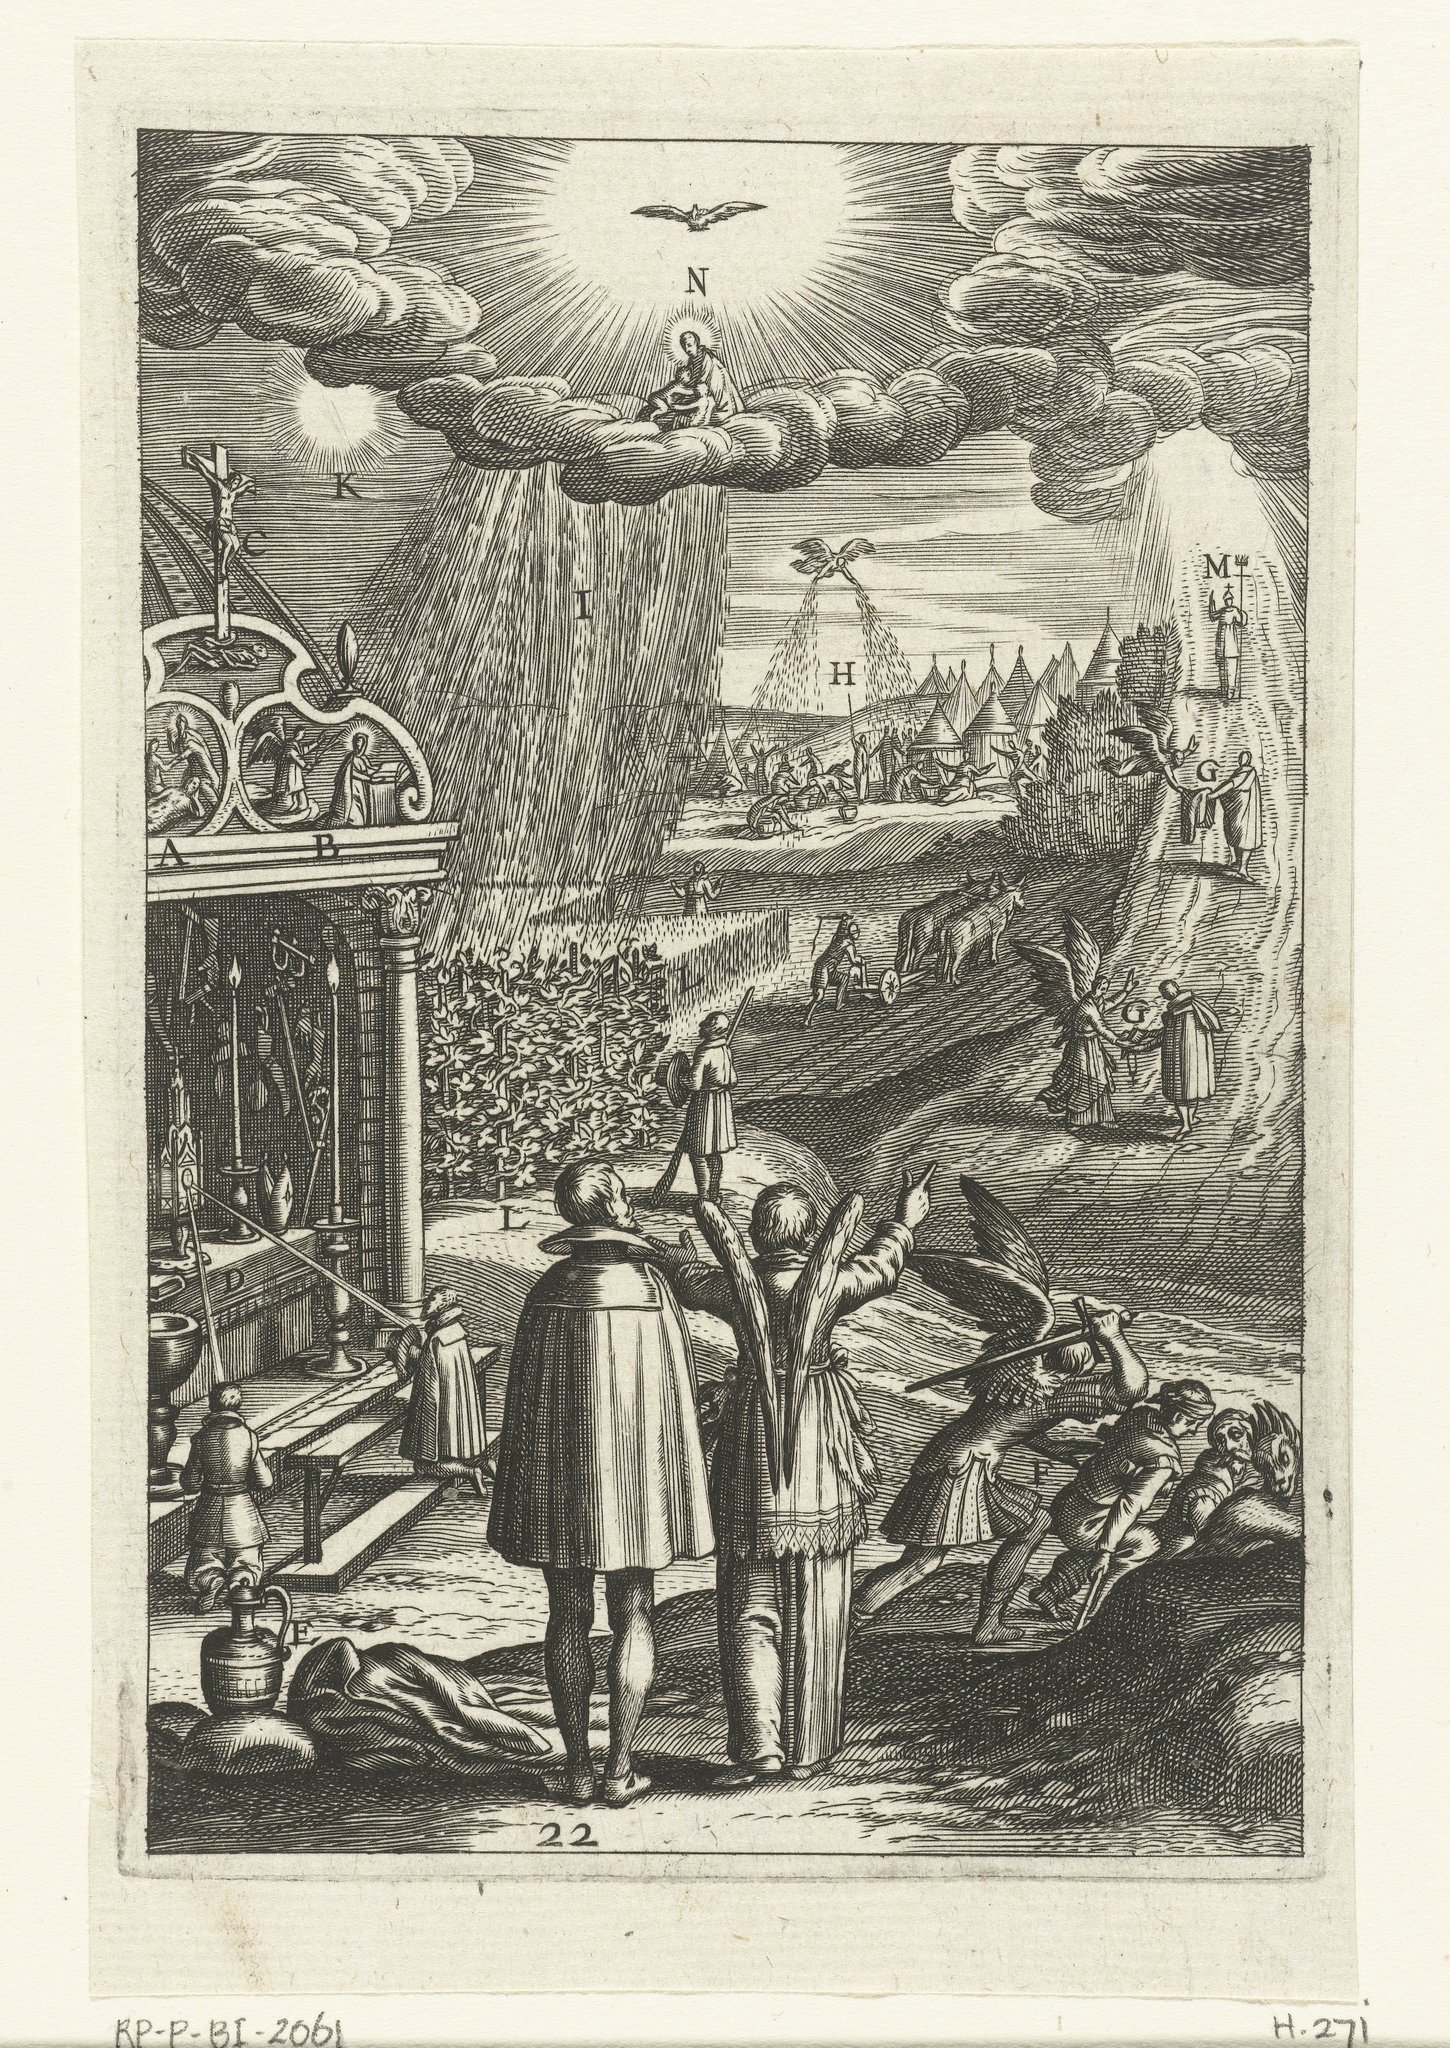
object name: book illustration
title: Embleem met engel die een man wijst op alle goede daden en gaven van God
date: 1620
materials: paper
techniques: engraving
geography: antwerp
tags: the life of man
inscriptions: collector's mark: Lugt 2228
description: Prent uit: Antoine Sucquet, Den wech des eeuwich levens, beschreven int latijn : met beelden verlicht door Boëtius a Bolsvert, Antwerpen, Hendrick Aertssens, 1620, afb. tegenover p. 538